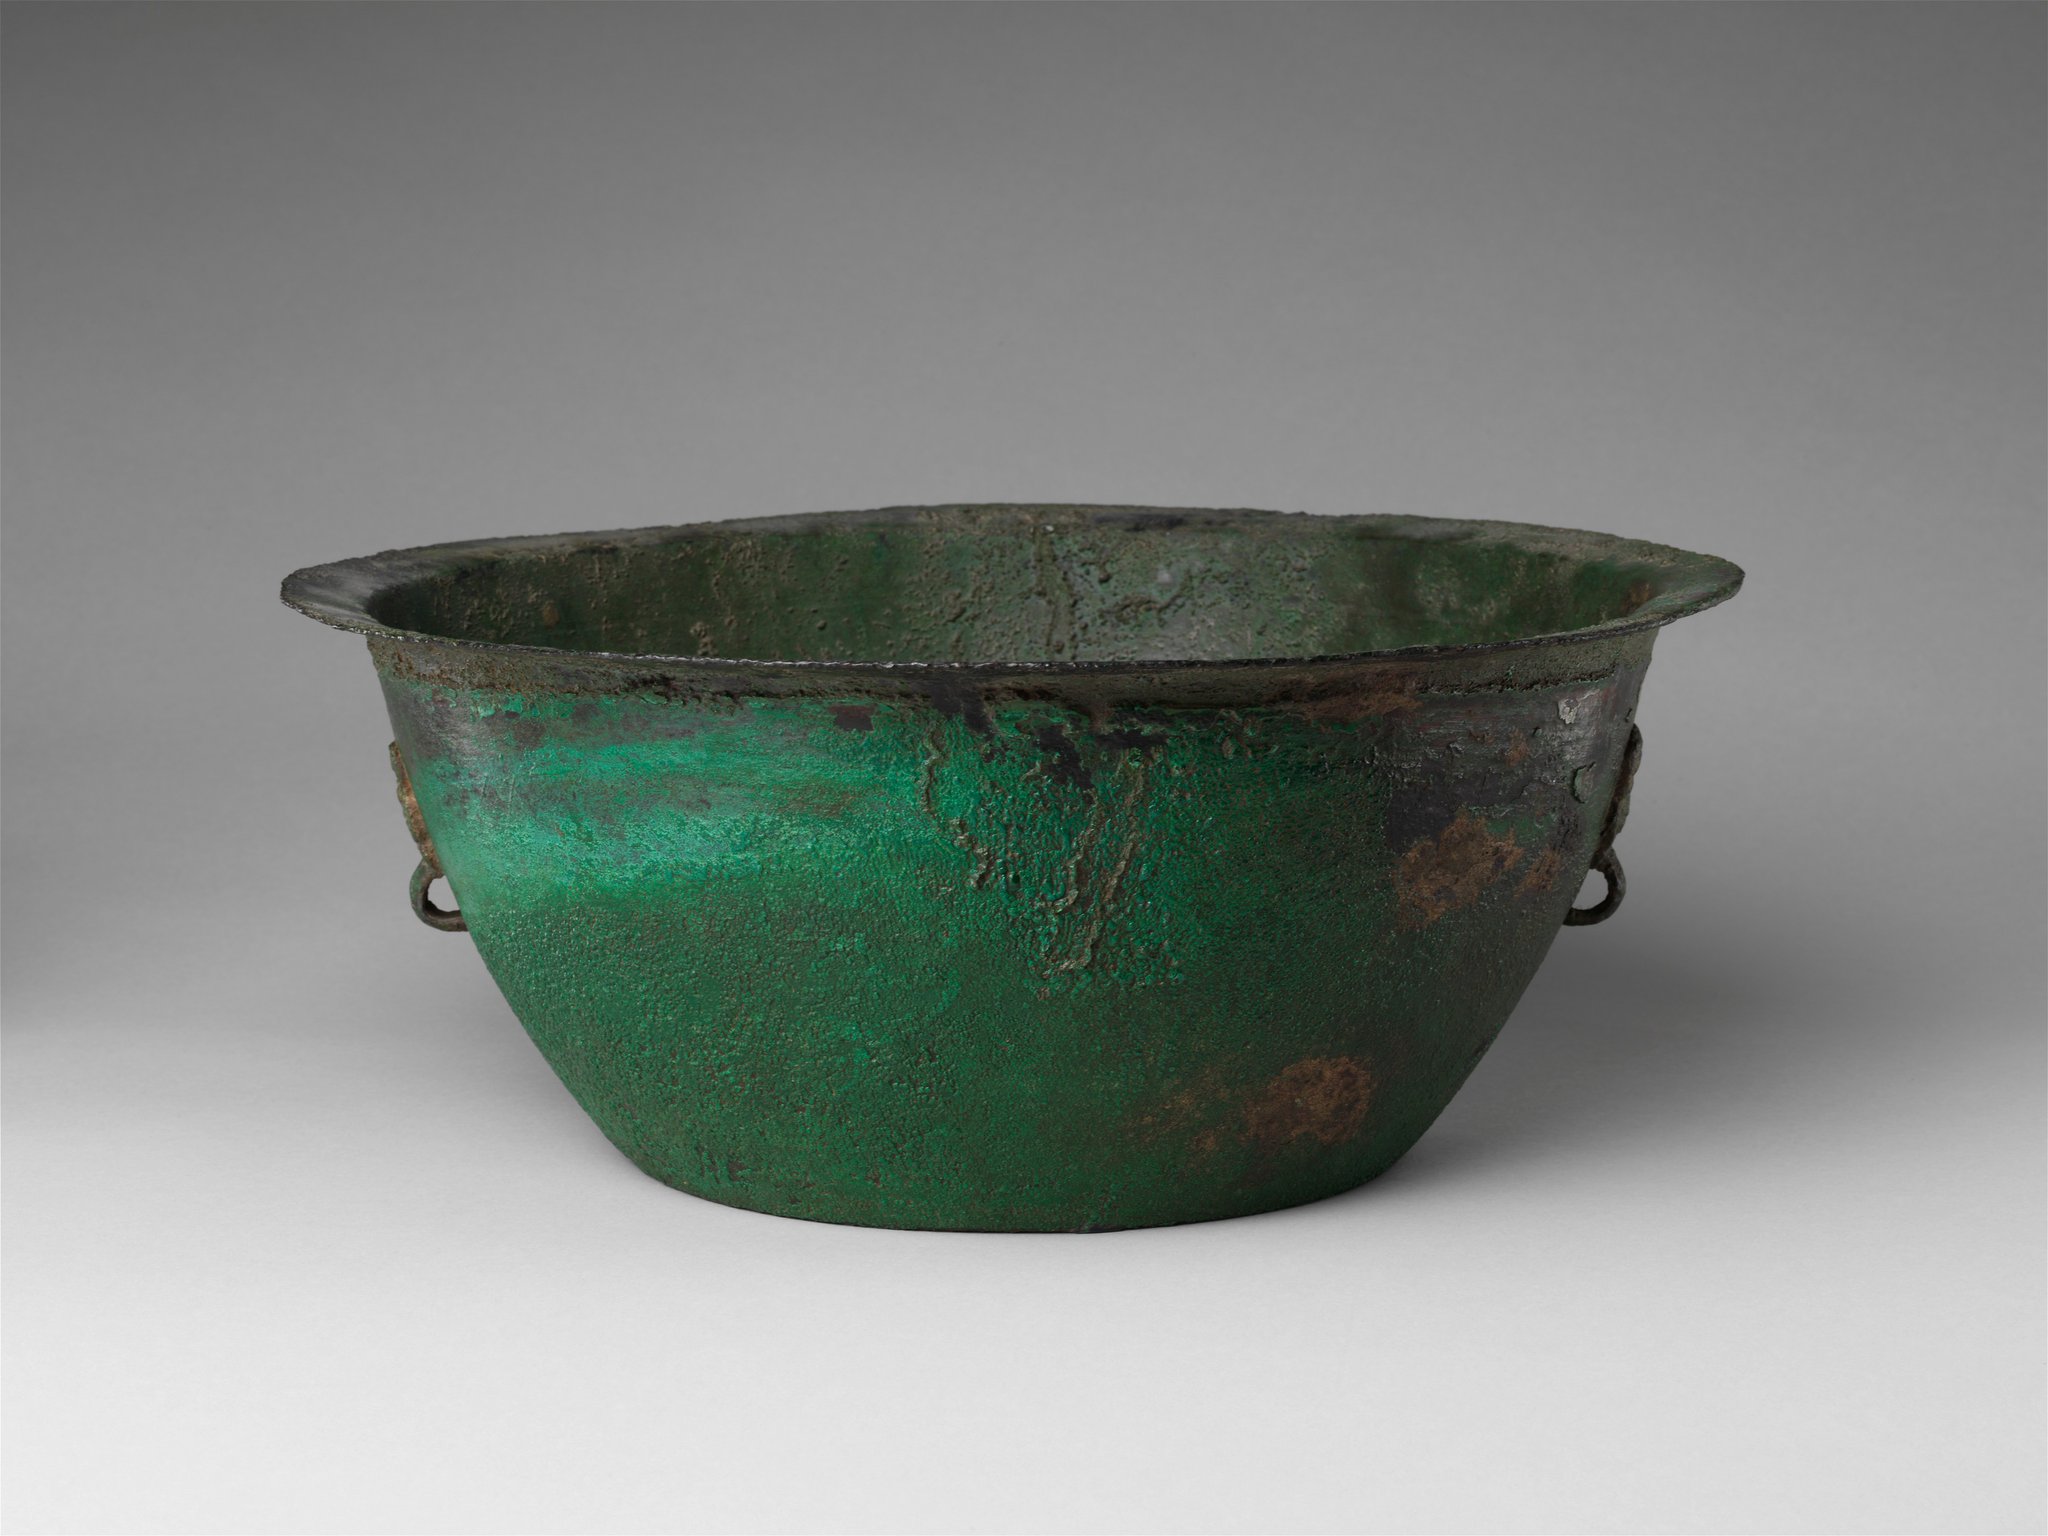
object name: bottom of a steamer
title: Bottom of a steamer (Fu)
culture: chinese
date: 206 BCE-220 CE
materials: bronze